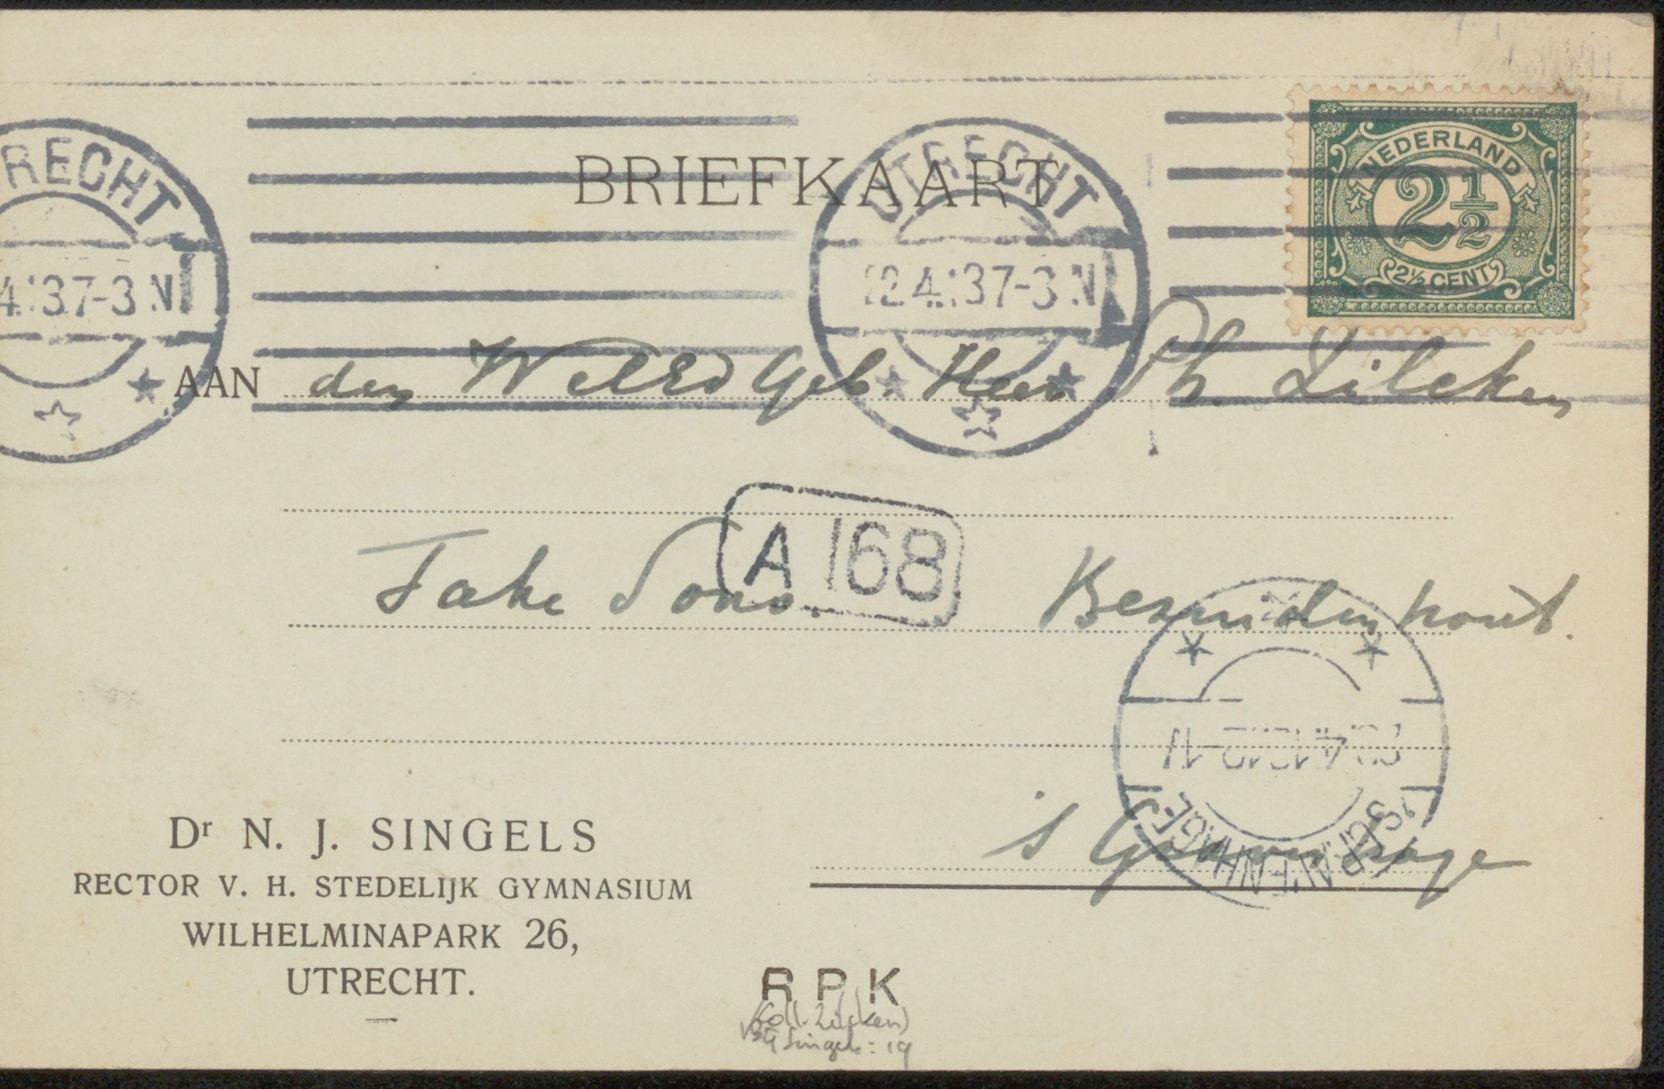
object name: postcard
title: Briefkaart aan Philip Zilcken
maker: n.j. singels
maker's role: leraar, schrijver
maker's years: 1857-1931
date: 1913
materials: cardboard, ink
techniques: pen, writing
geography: utrecht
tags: the hague, painter, draughtsman, philip zilcken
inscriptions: collector's mark: ‘RPK’